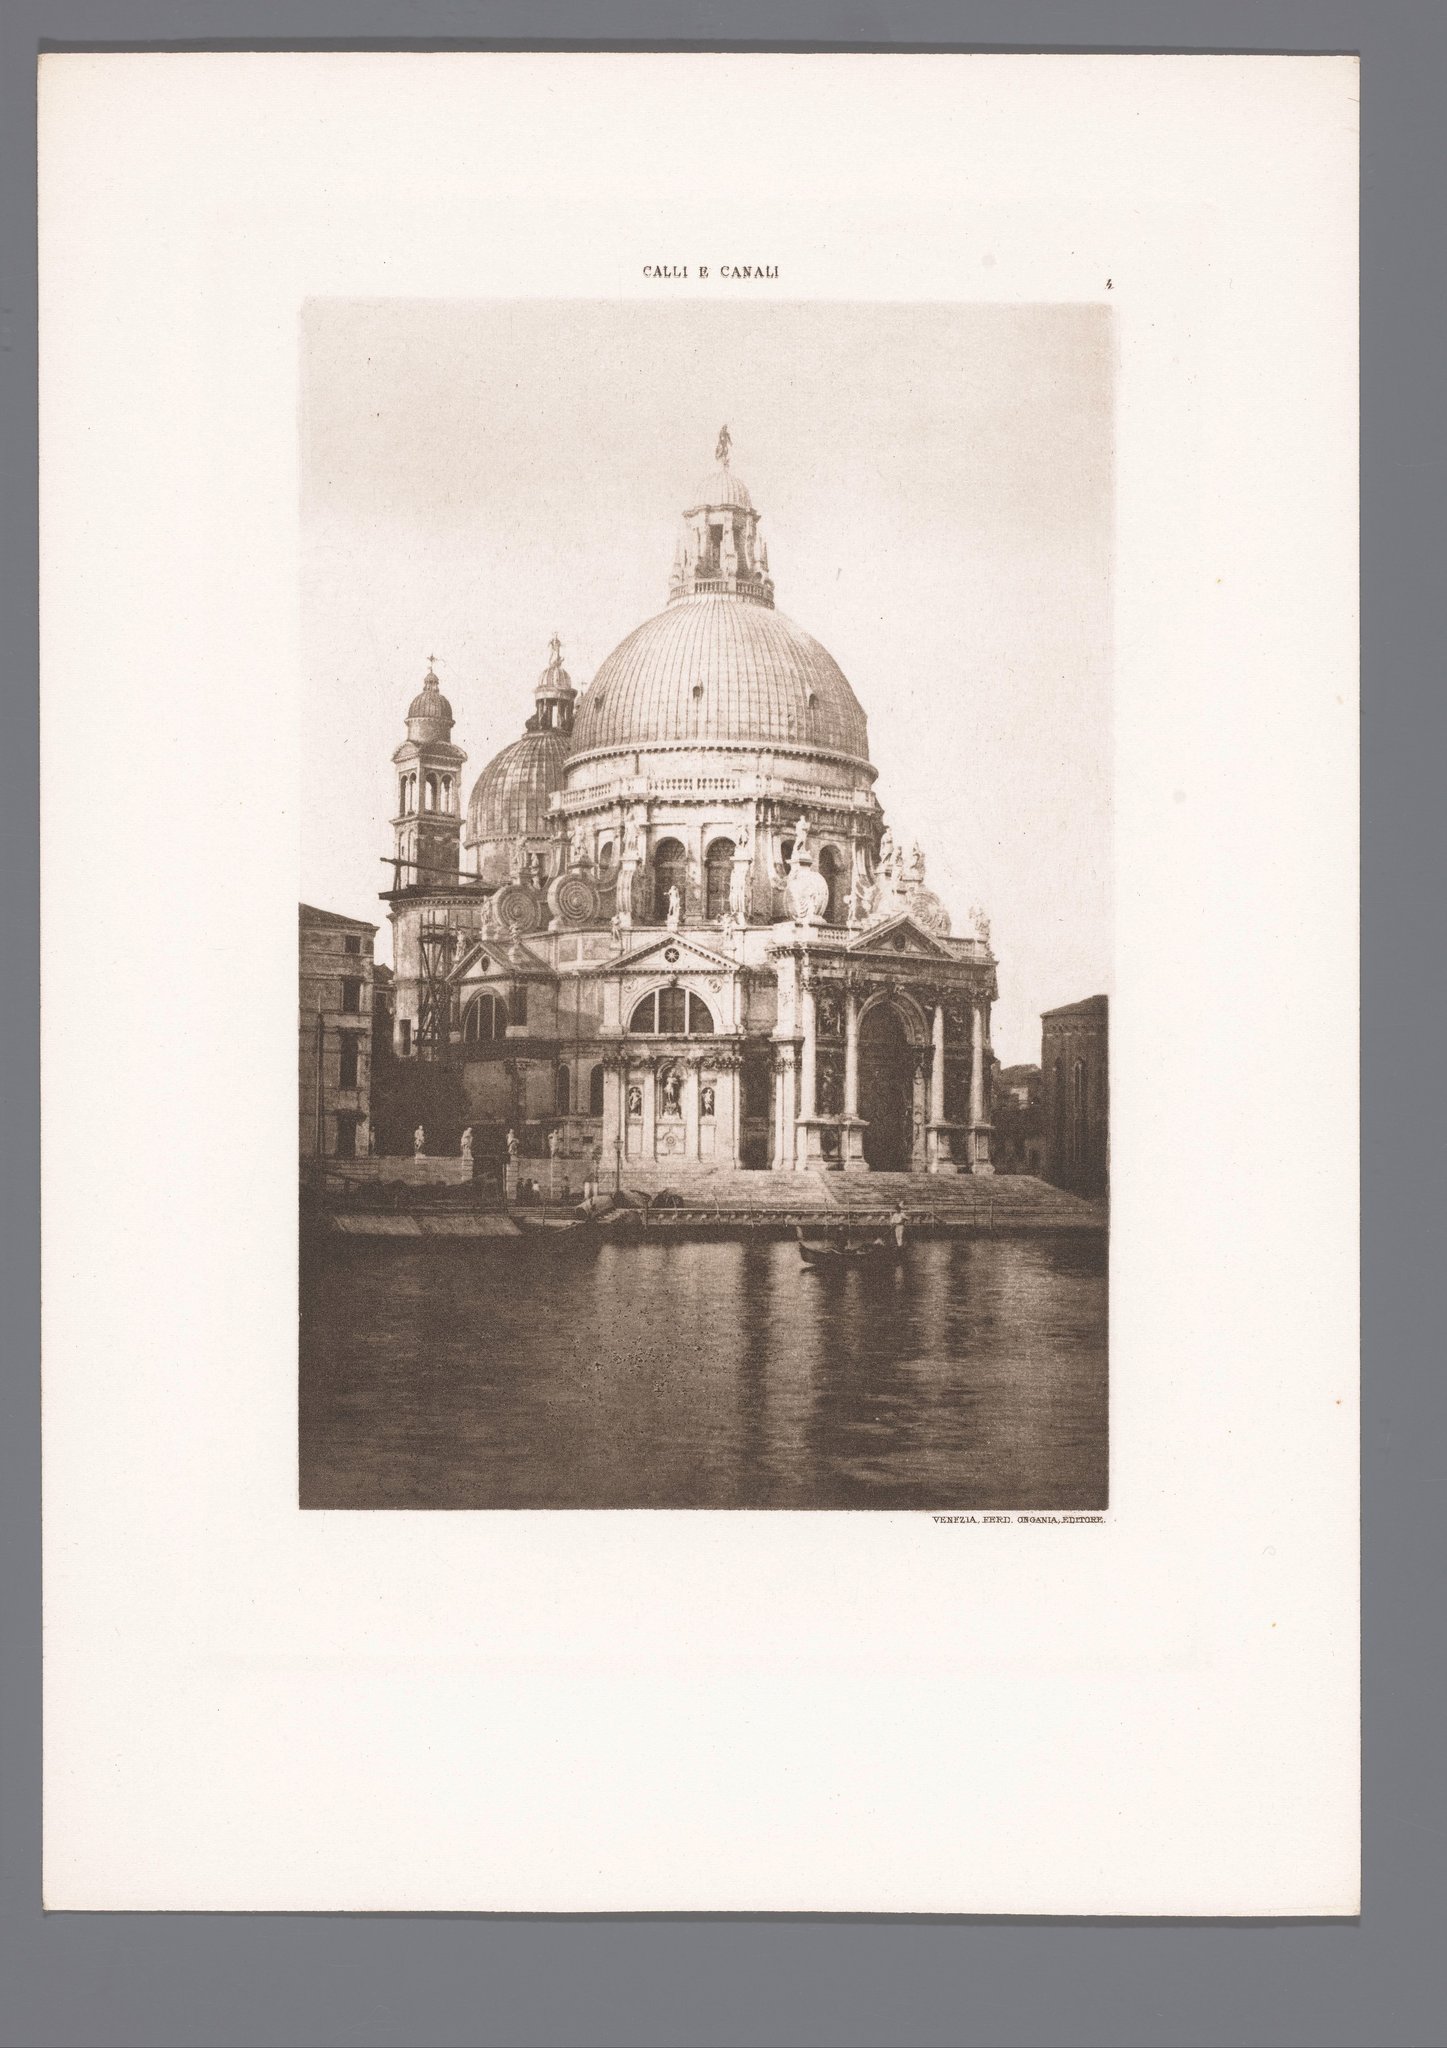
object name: page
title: Calli e canali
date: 1888-1898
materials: paper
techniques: photoaquatint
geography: venice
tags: canal, church (exterior)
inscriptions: inscription: ‘h’